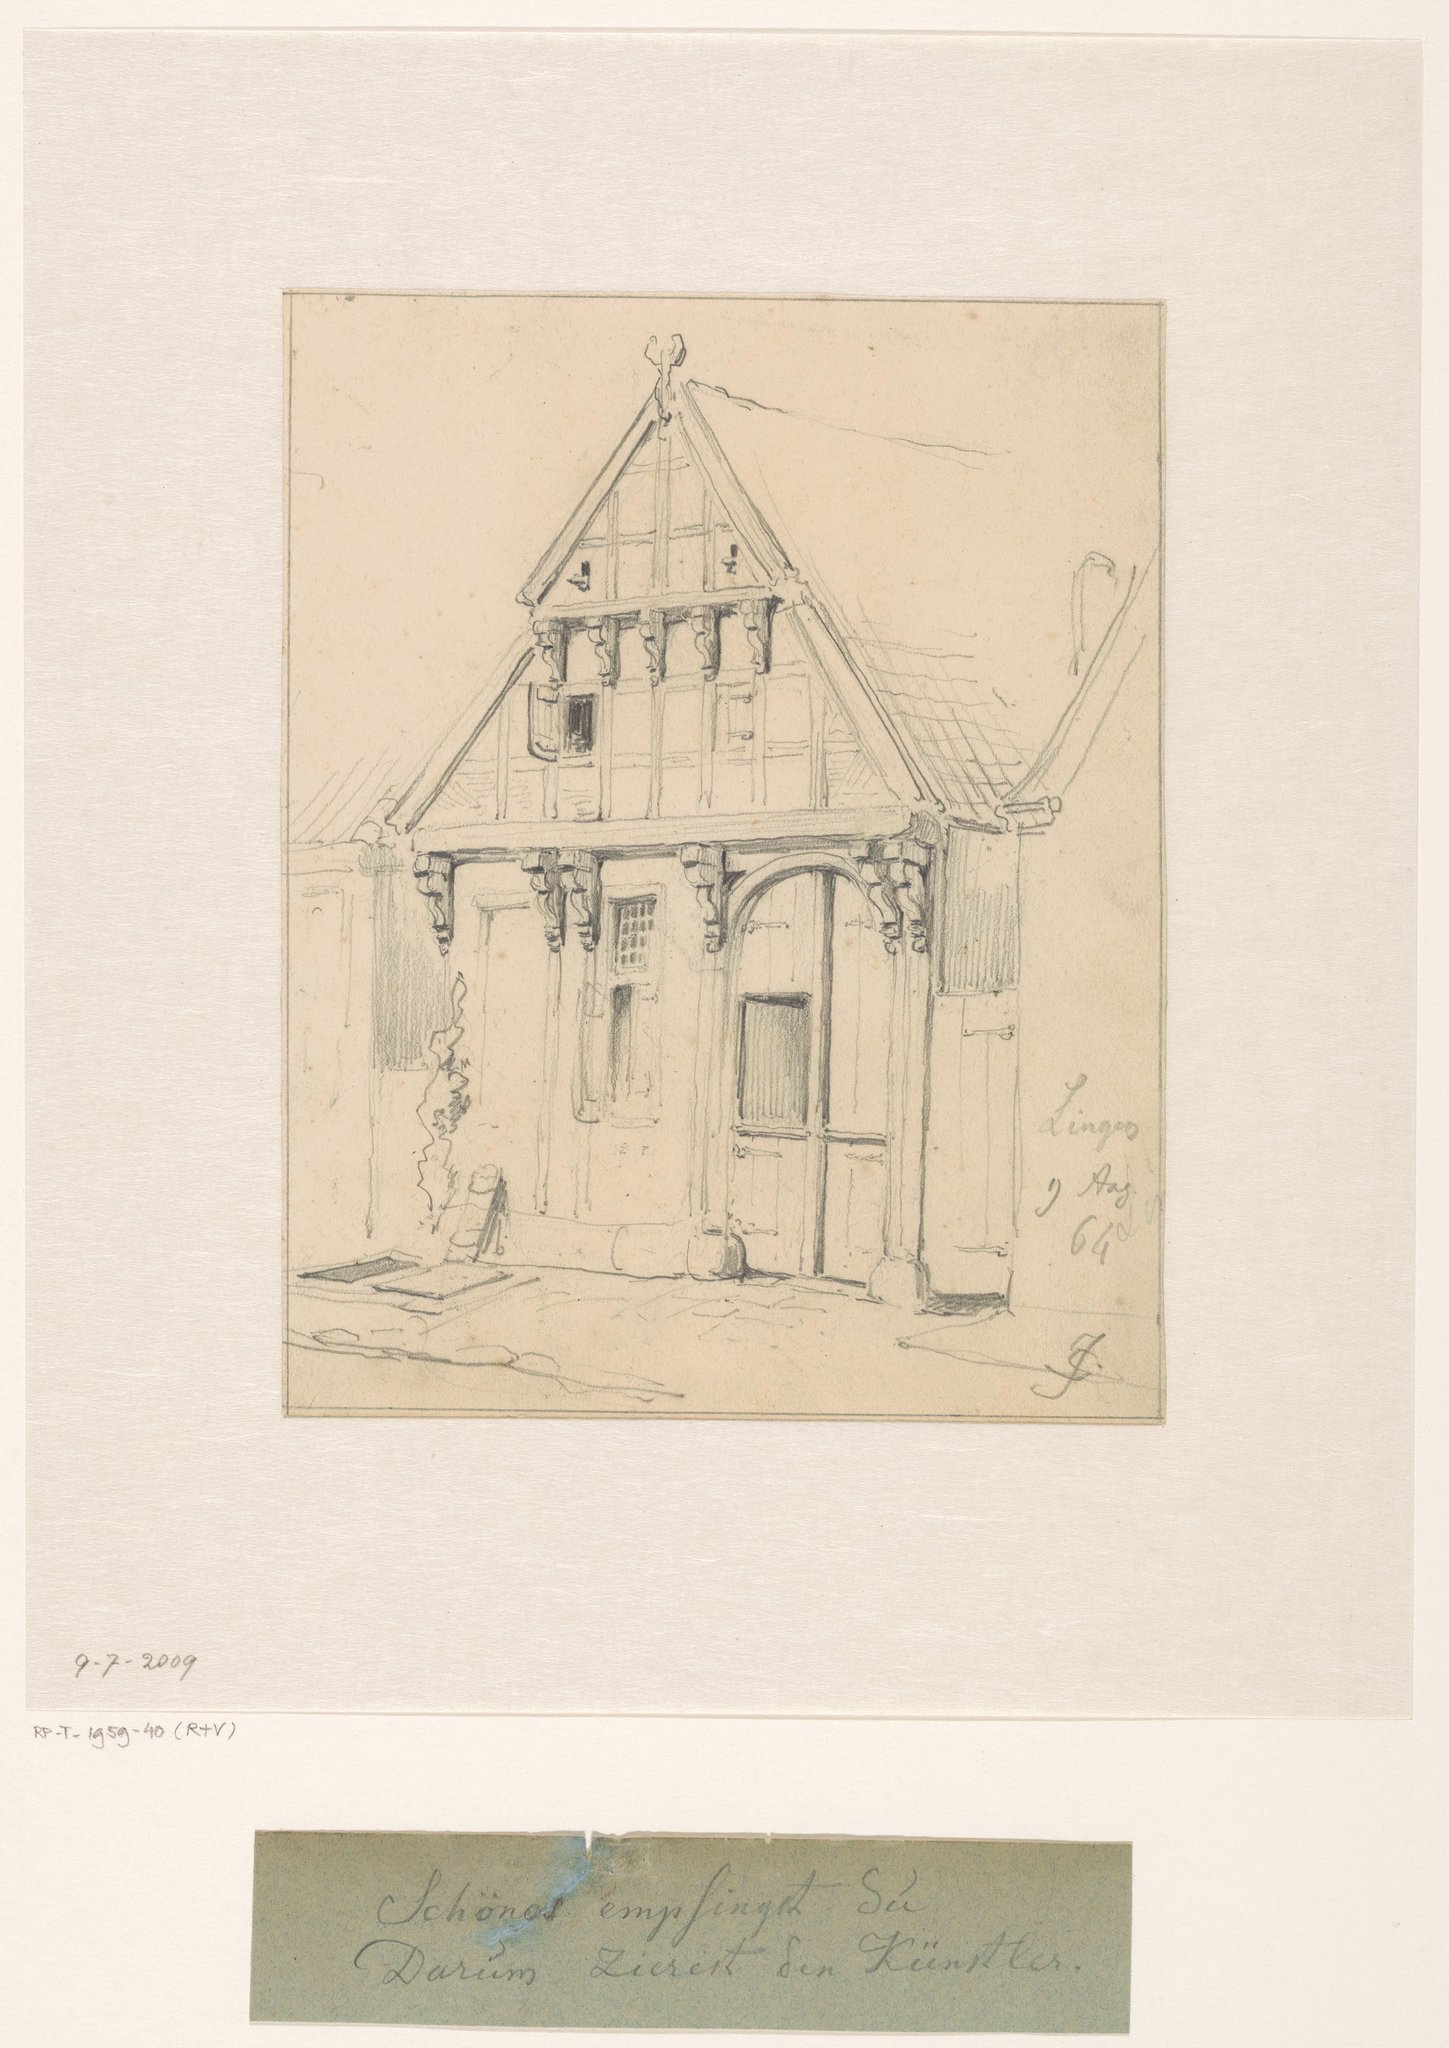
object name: drawing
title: Houten gevelpartij van een huis te Lingen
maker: jan striening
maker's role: draughtsman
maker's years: 1827-1903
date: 1864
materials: paper, pencil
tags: façade (of house or building)